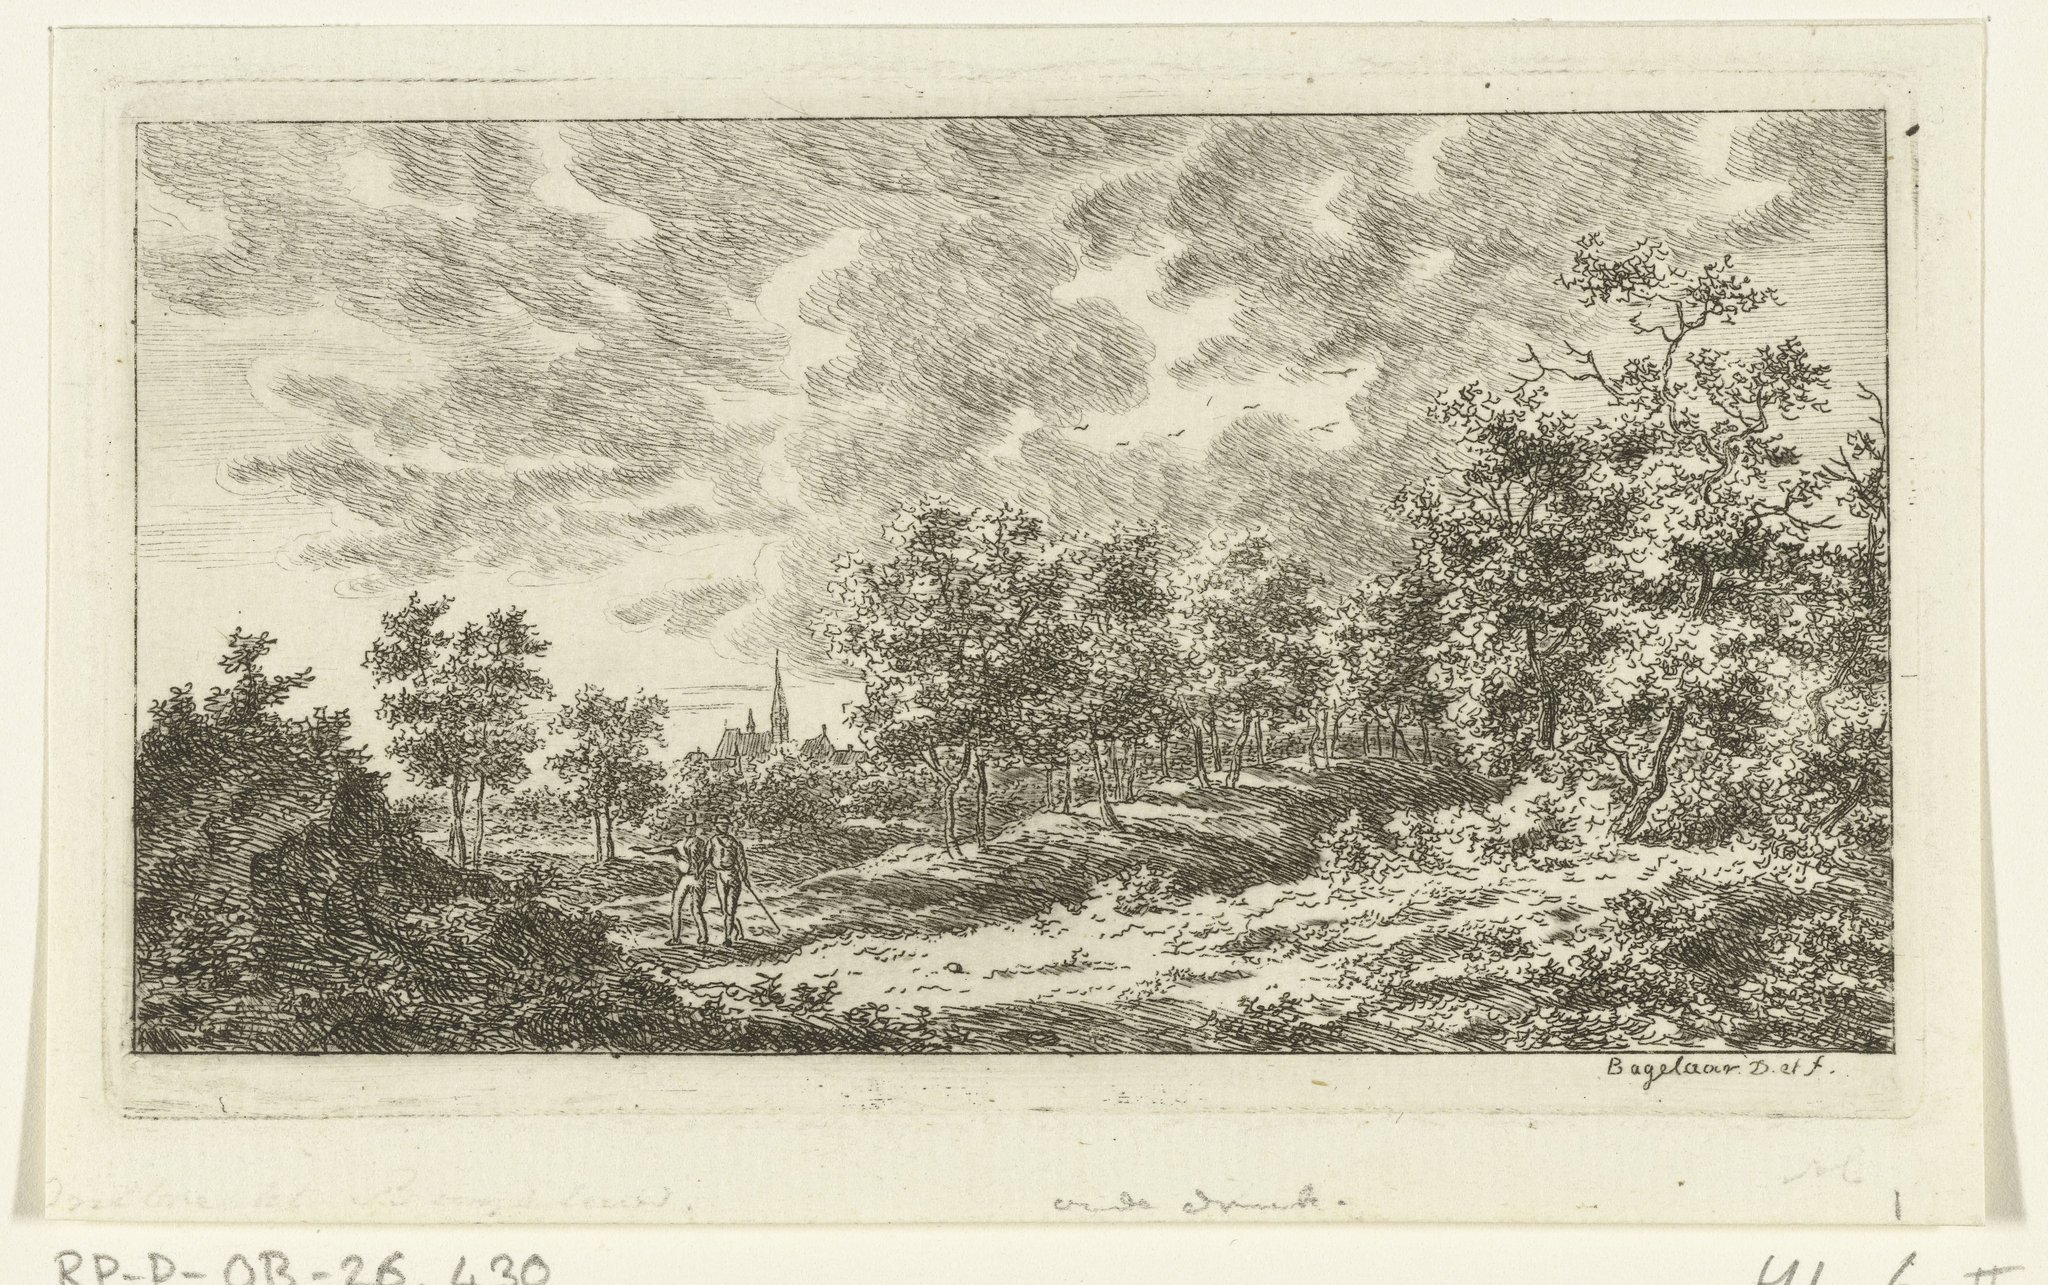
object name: print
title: Landschap met twee wandelaars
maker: ernst willem jan bagelaar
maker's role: draughtsman, print maker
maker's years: 1775-1837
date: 1798-1837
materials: paper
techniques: drypoint, etching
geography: netherlands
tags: landscapes in the temperate zone (+ landscape with figures, staffage)